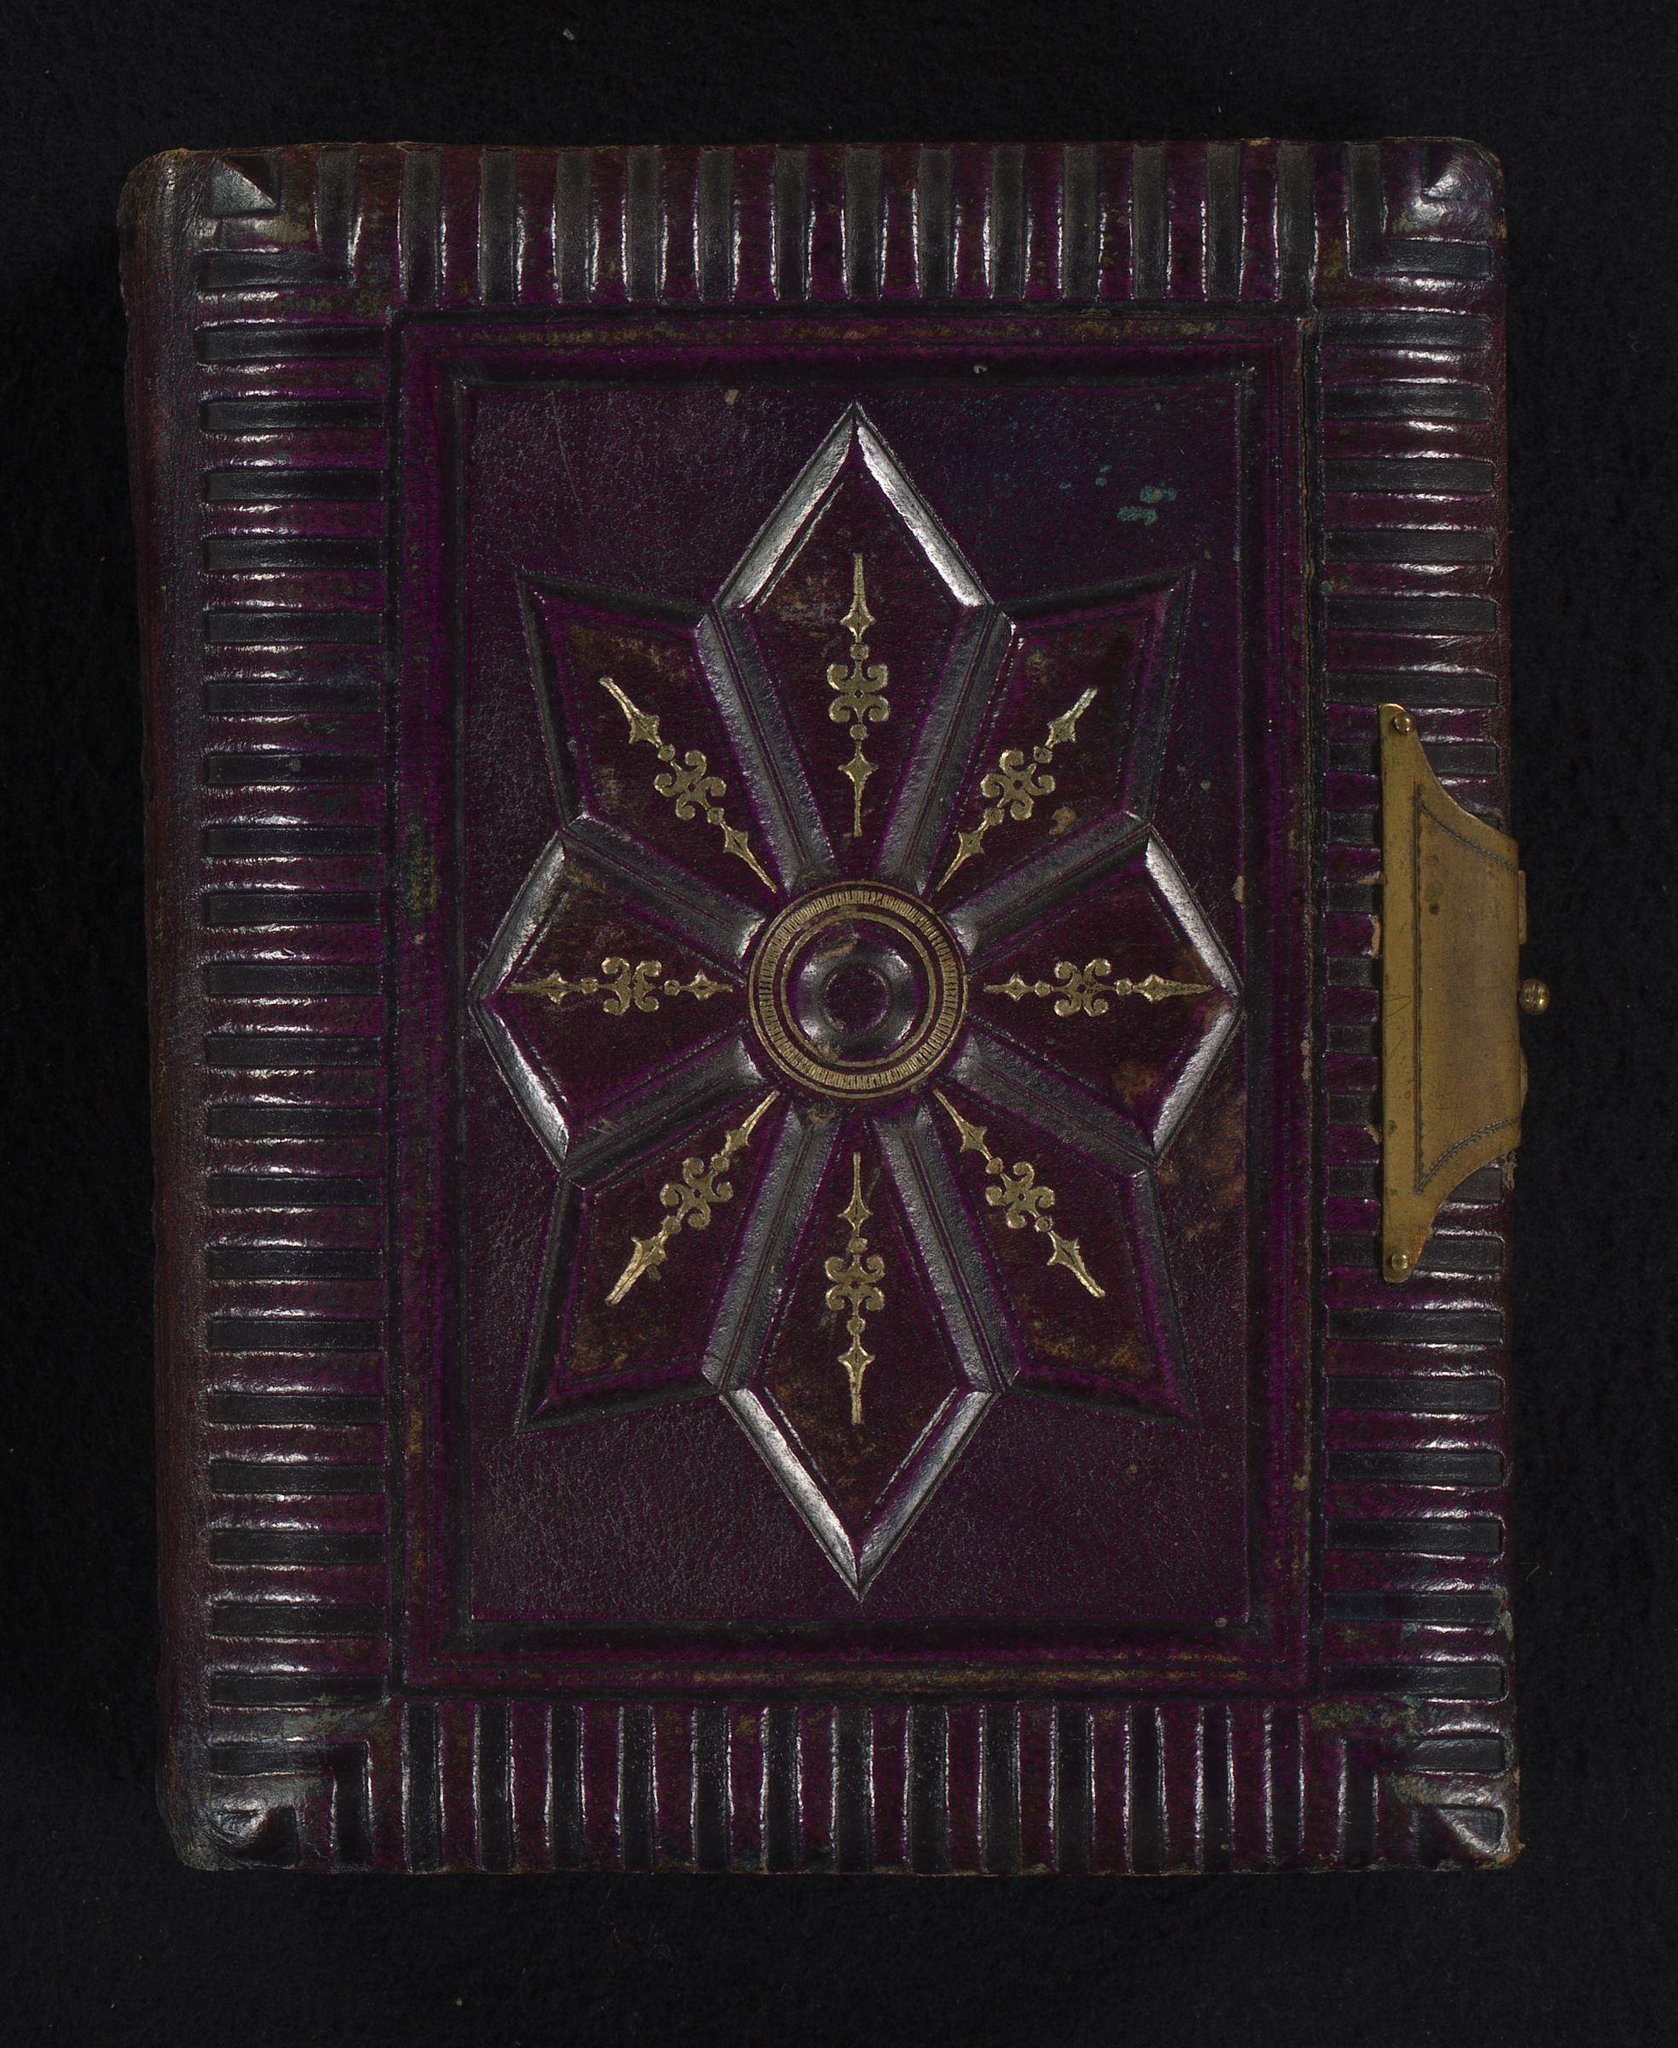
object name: slip in album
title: Fotoalbum met 43 foto's, Spaans en Cubaans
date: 1860-1900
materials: cardboard, leather, metal, paper, photographic support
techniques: albumen print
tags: sideburns, historical persons - bb - woman, boy (child between toddler and youth), moustache, historical persons, girl (child between toddler and youth), head-gear: hat, beard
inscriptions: collector's mark: ‘Dienst Verspreide Rijkscollekties/ Inv.nr: A742’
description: Fotoalbum met 43 foto's op 25 bladen. Het album bevat portretten, vervaardigd in Spanje en Cuba (Havana) met uitzondering van één portret dat is vervaardigd in Algerije. De foto's zijn onder andere vervaardigd door Antonio Sorgato, Esteban Mestre en C.D. Fredricks y Daries, enkele foto's zijn anoniem.